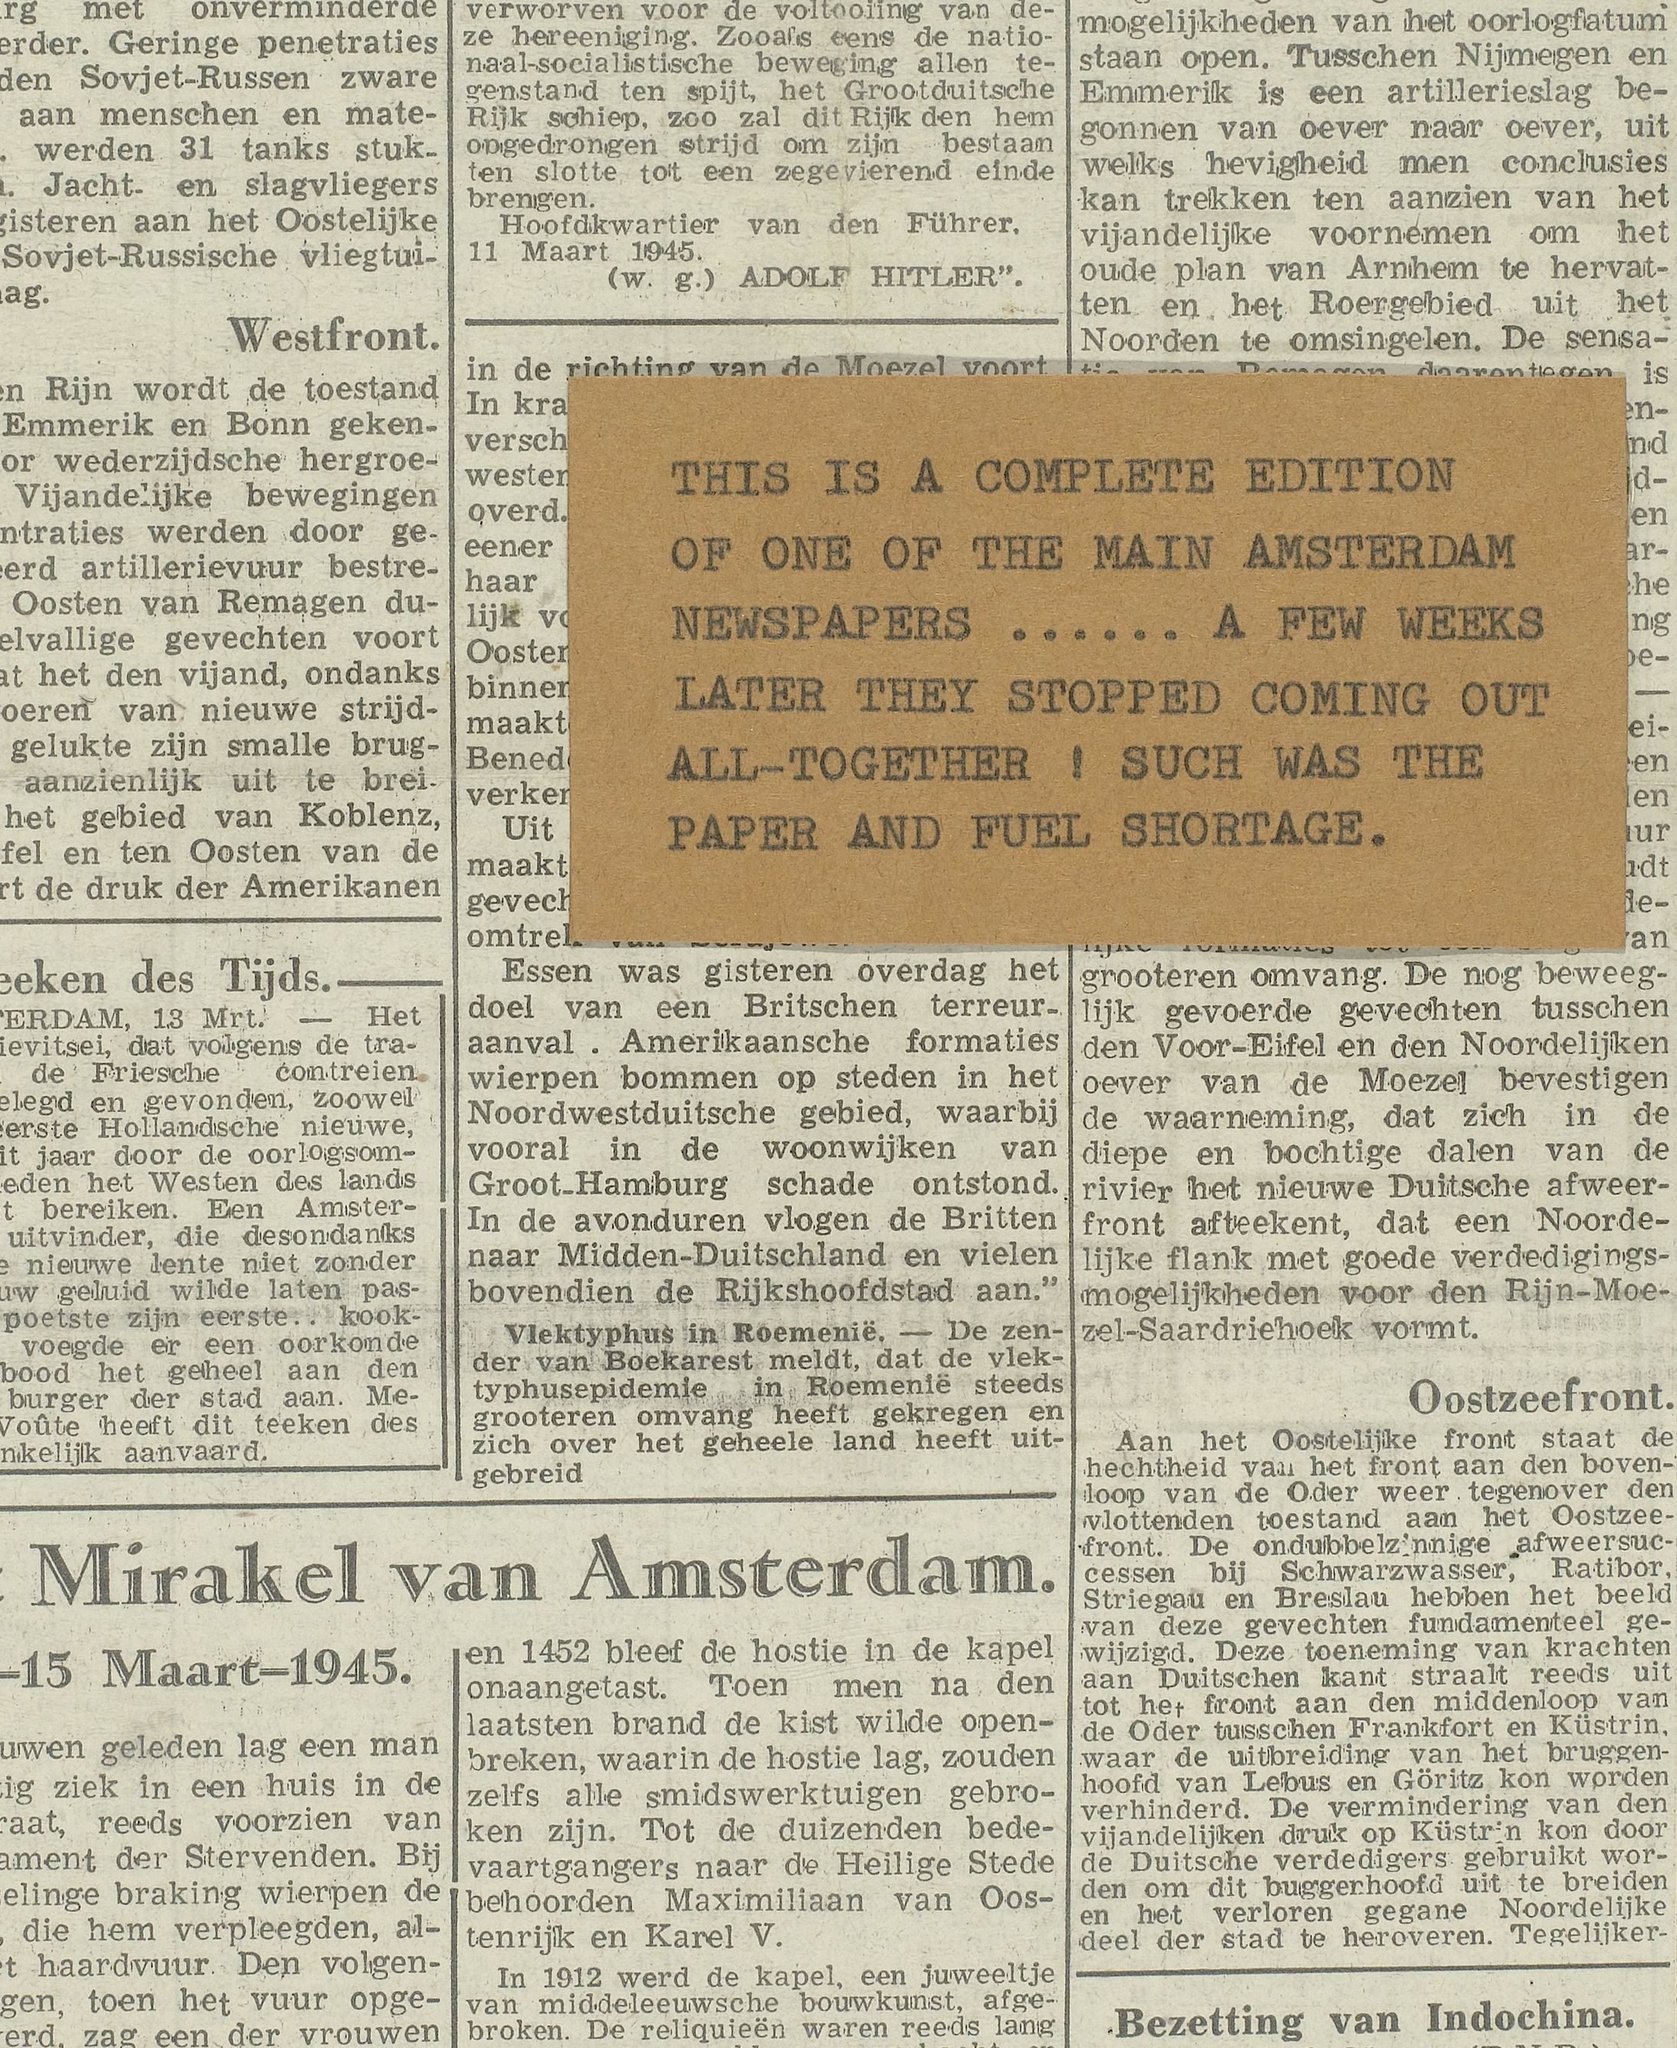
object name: album leaf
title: De Telegraaf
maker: Anonymous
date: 1945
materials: paper, plastic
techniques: printing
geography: amsterdam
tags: amsterdam, tonny van renterghem, berlin, fritz kahlenberg, underground movement, partisans, newspaper, news-sheet, netherlands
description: Dagblad De Telegraaf van maart 1945, kort daarna verscheen het blad niet meer vanwege gebrek aan papier en brandstof.